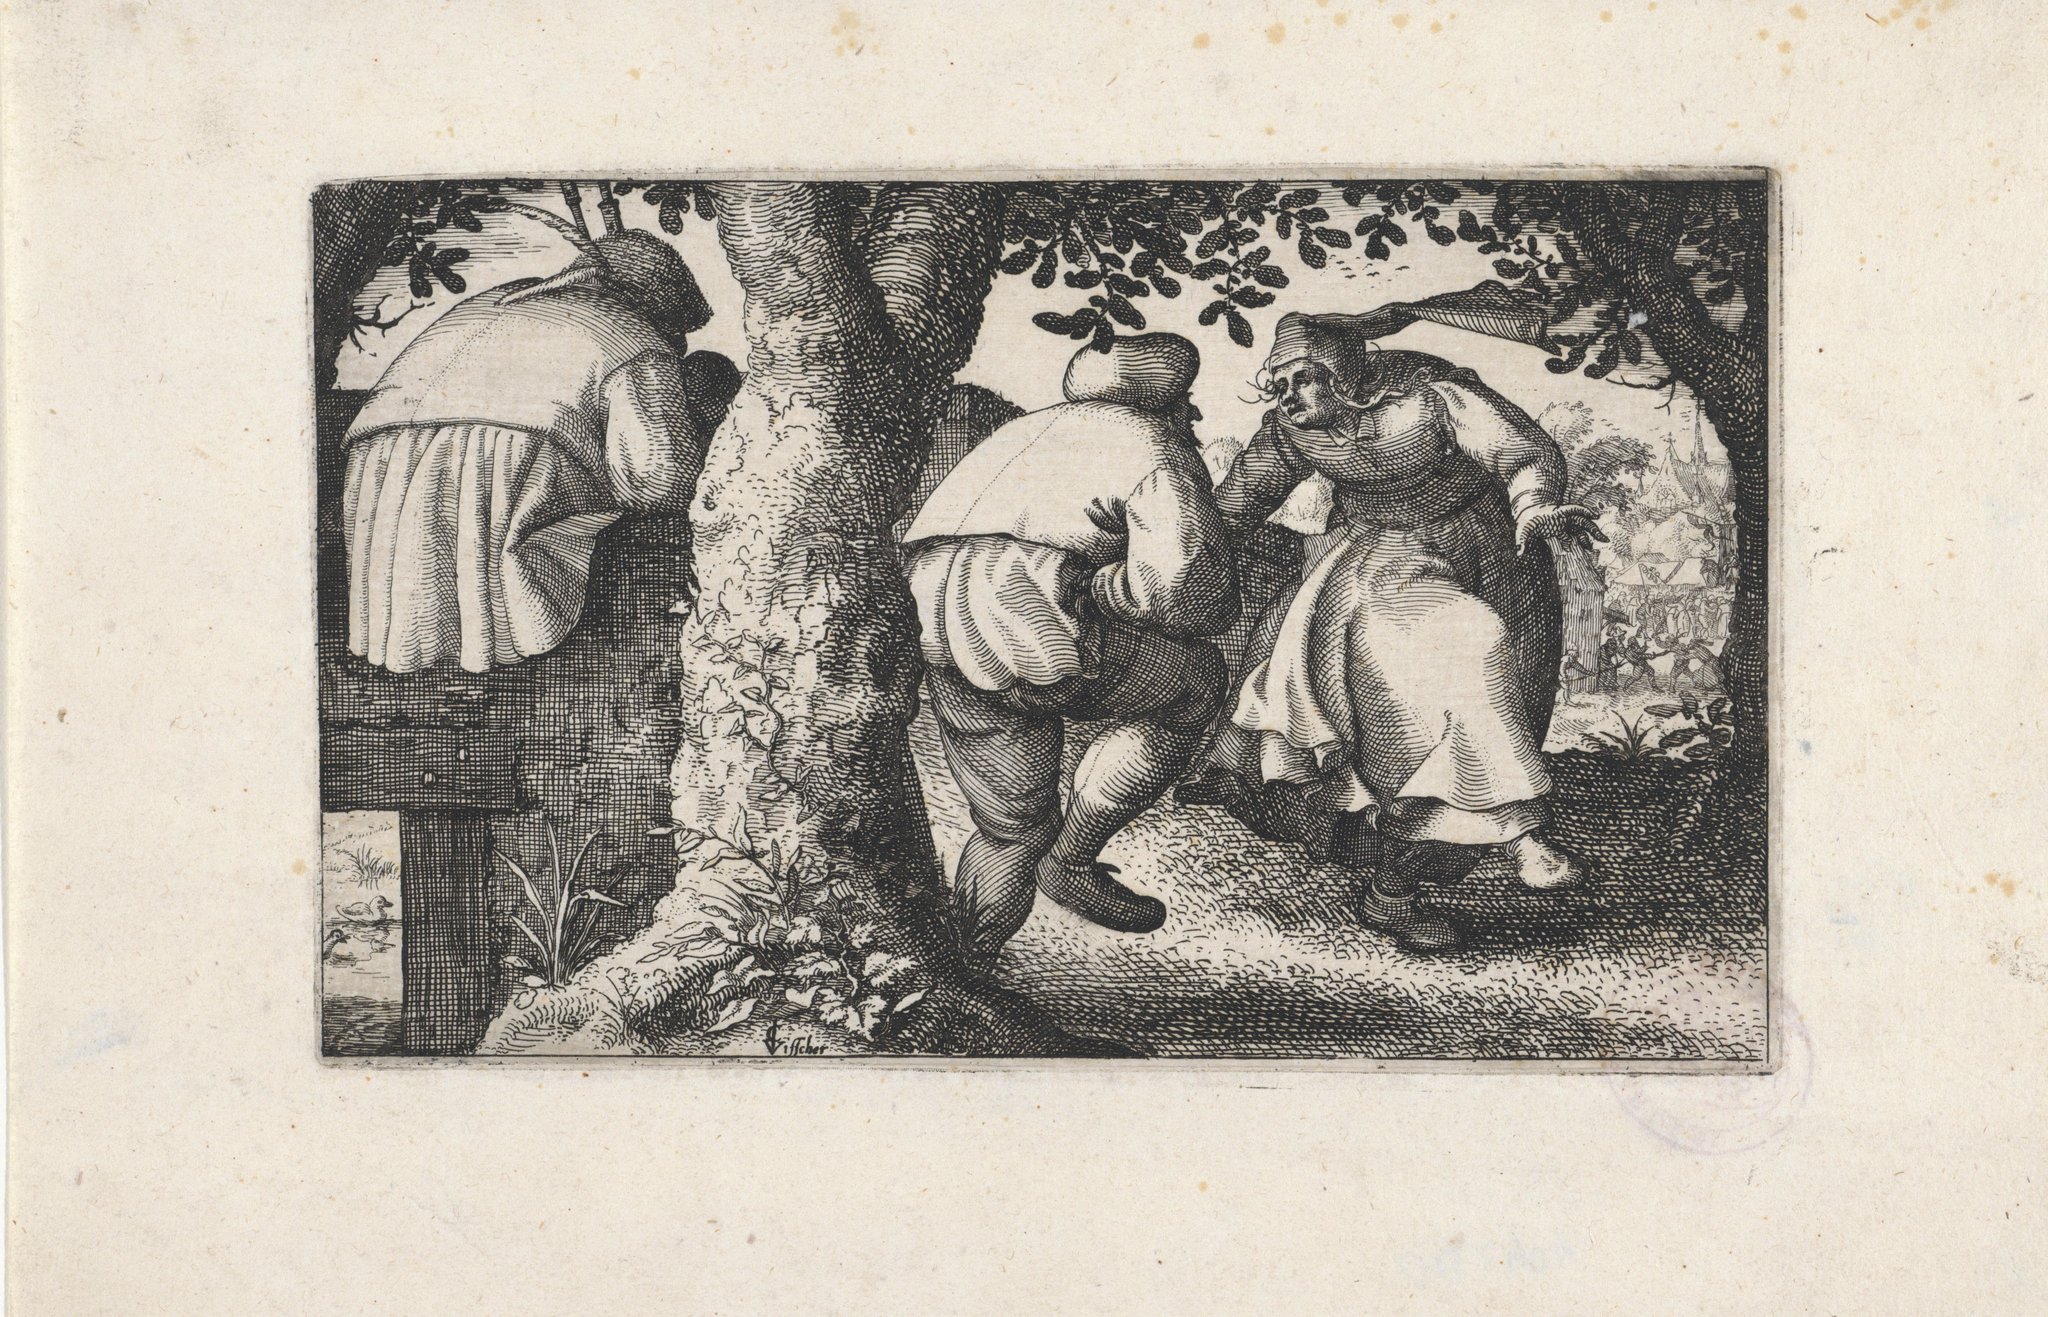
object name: print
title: Dansend boerenpaar bij doedelzakspeler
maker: claes jansz. visscher (ii)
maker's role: draughtsman, print maker, publisher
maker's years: 1586-1652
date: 1596-1630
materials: paper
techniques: etching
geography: amsterdam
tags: bagpipe, musette, one pair dancing; man and woman dancing as a couple, farmers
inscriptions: collector's mark: Lugt 240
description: Dansend boerenpaar onder de bomen. Linksvoor zit een doedelzakspeler op een hekje. Op de achtergrond rechts een boerengevecht.